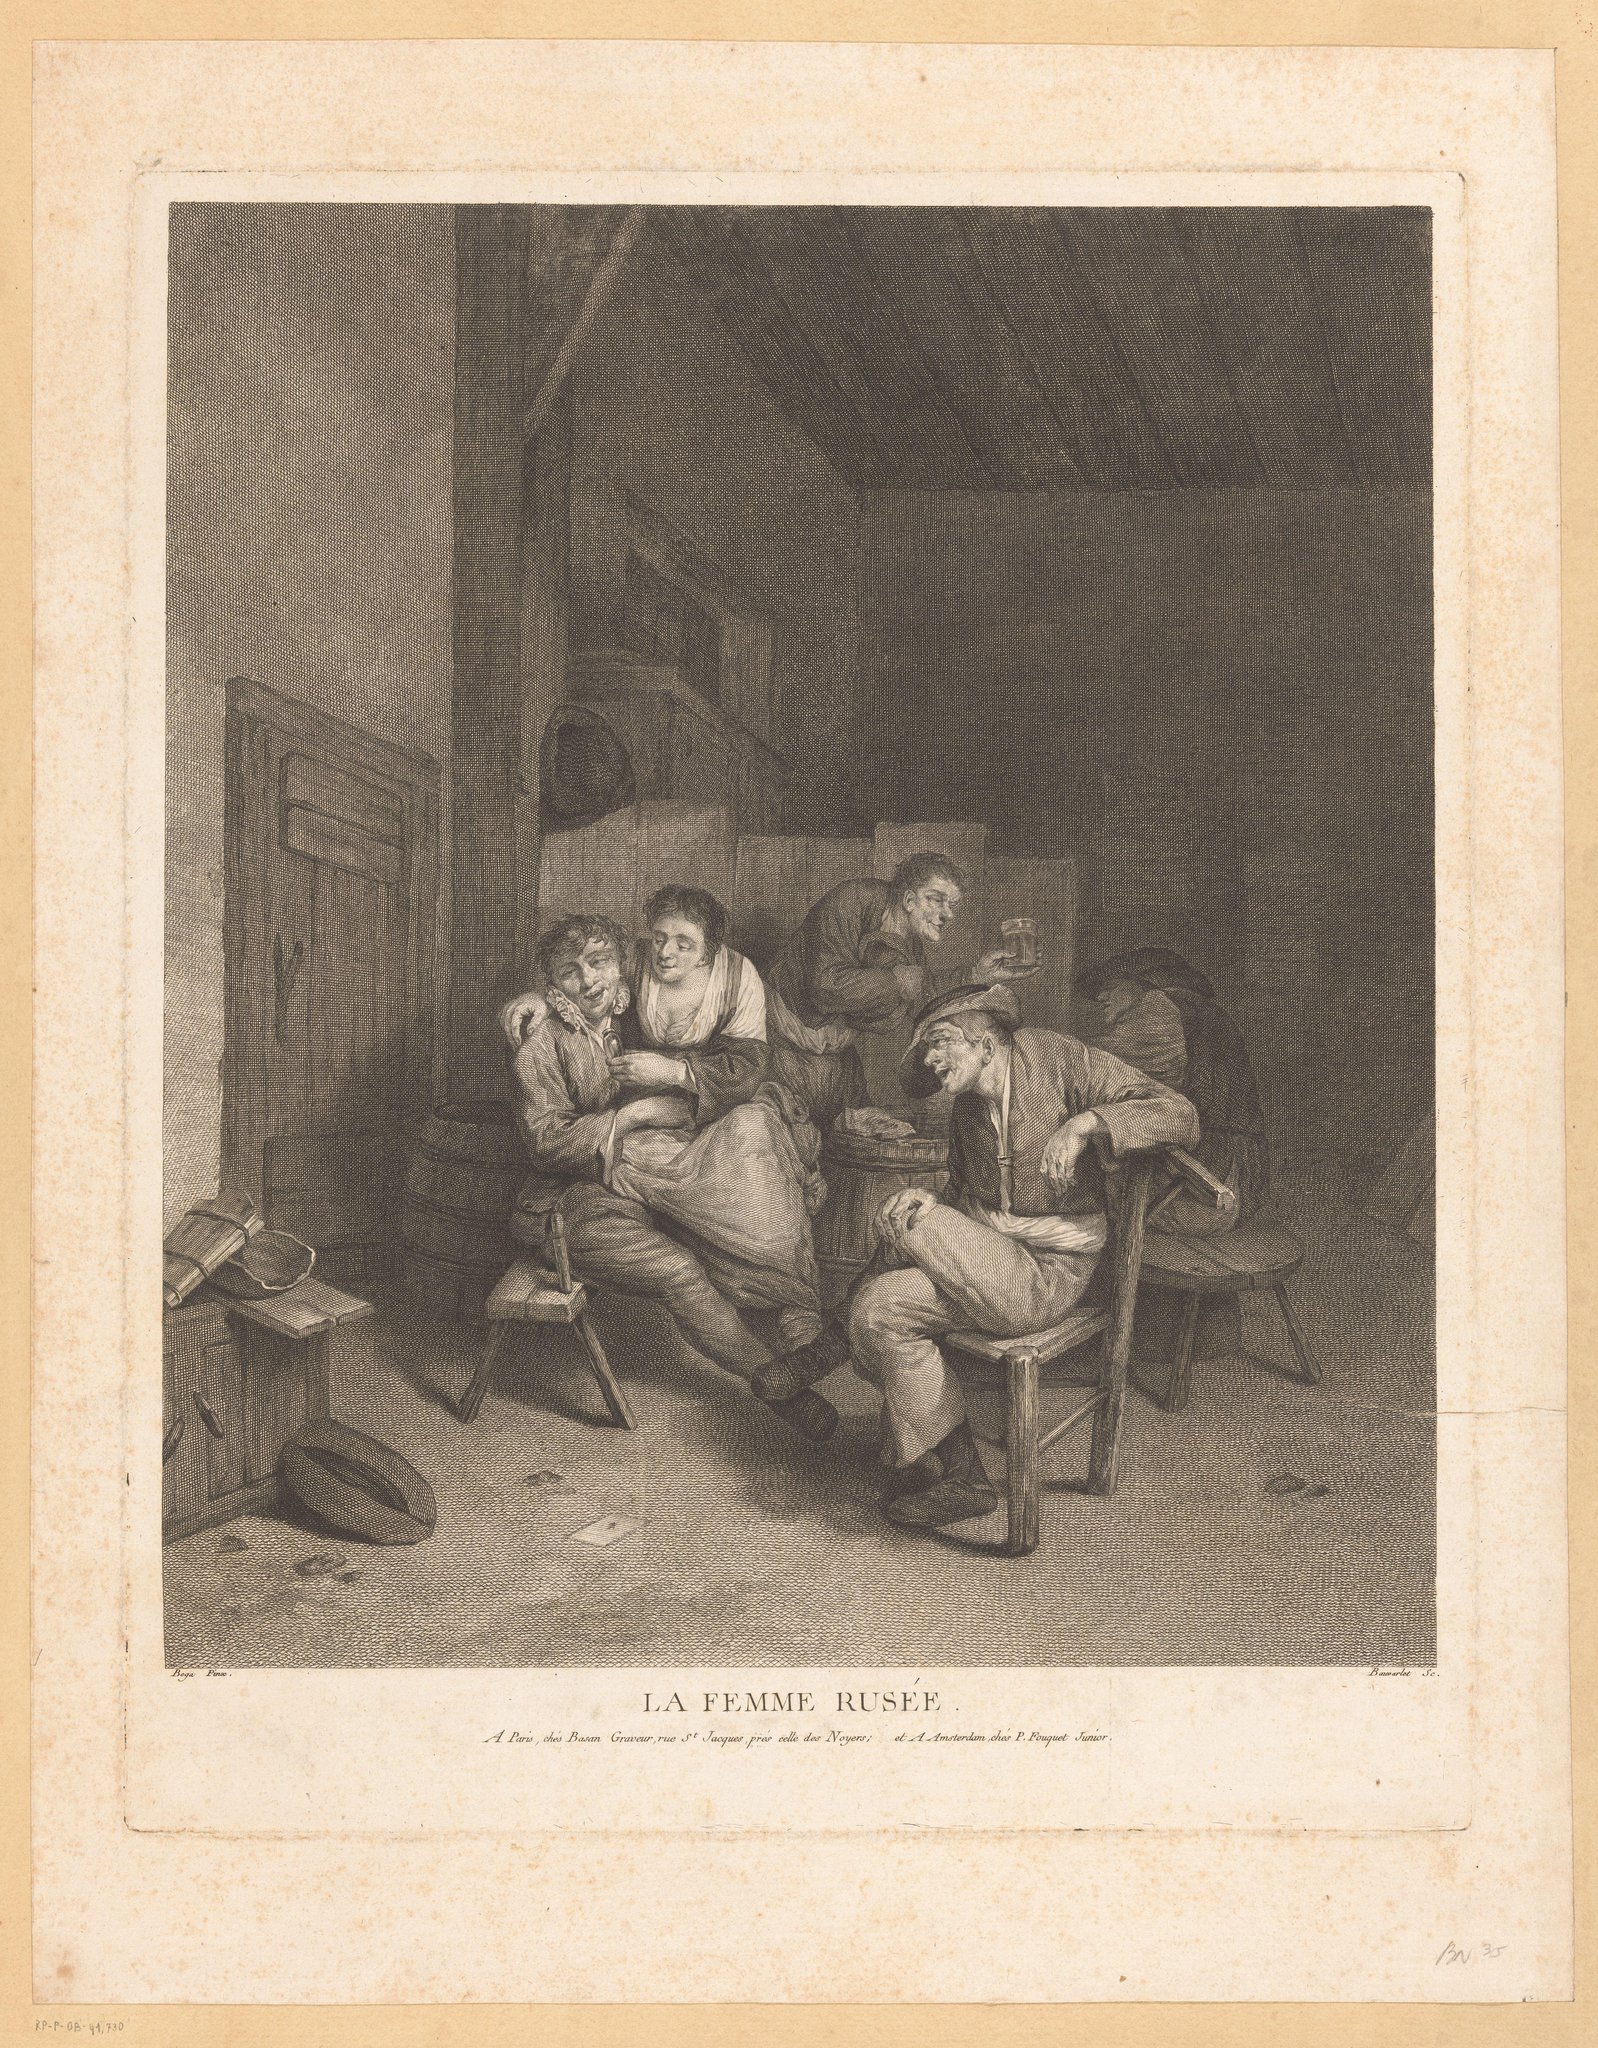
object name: print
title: La femme rusée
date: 1741-1797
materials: paper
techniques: etching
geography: paris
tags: the mind affected by drink, drugs or stimulants, hotel, hostelry, inn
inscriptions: collector's mark: Lugt 240